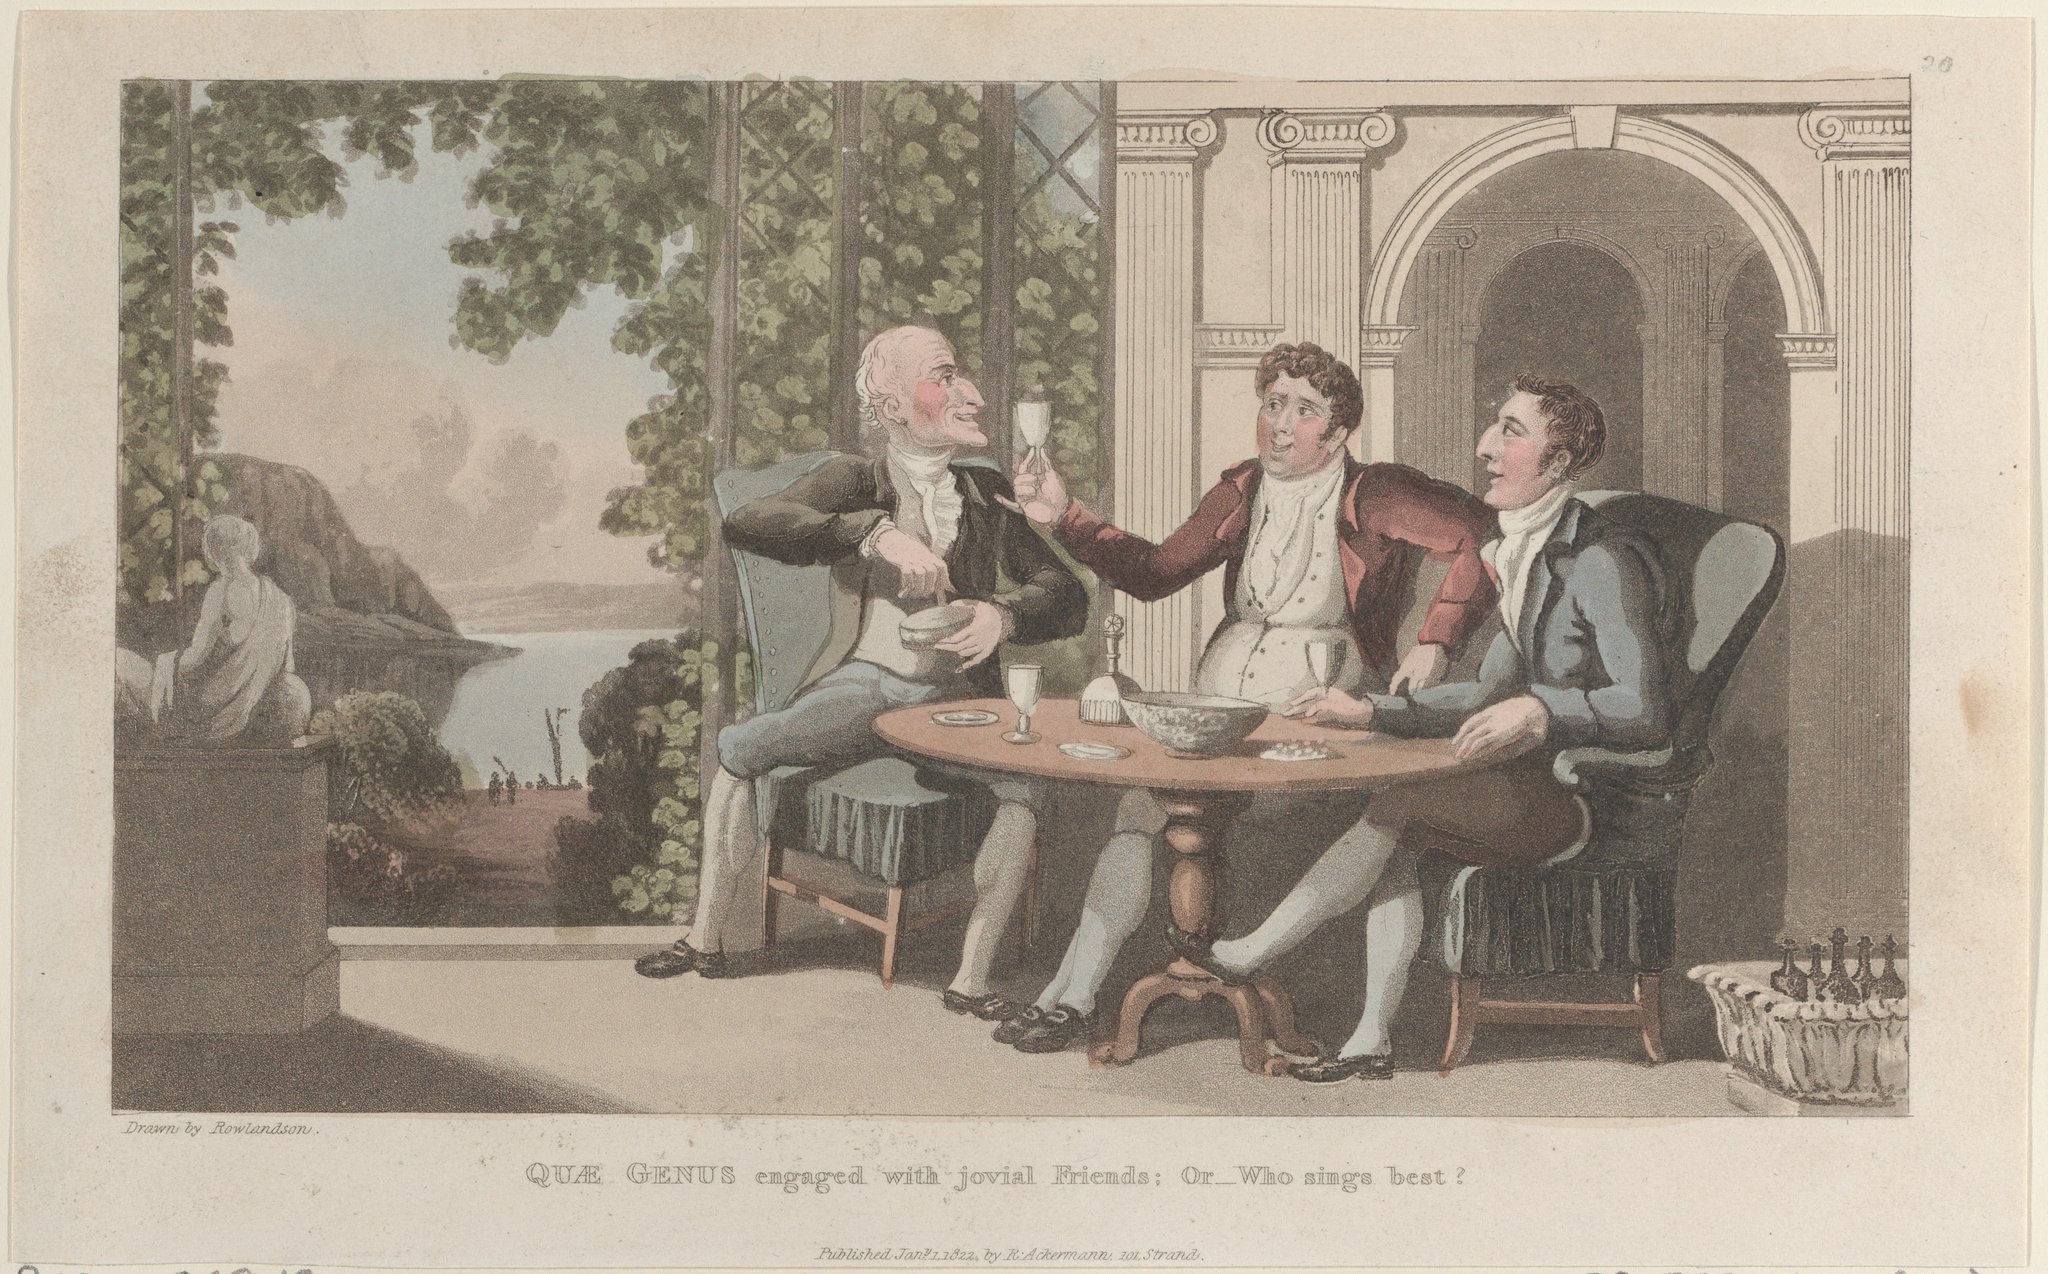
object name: print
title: Quae Genus Engaged with Jovial Friends; Or–Who Sings Best?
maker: thomas rowlandson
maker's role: artist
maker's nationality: british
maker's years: 1757-1827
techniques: aquatint, etching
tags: men,drinking